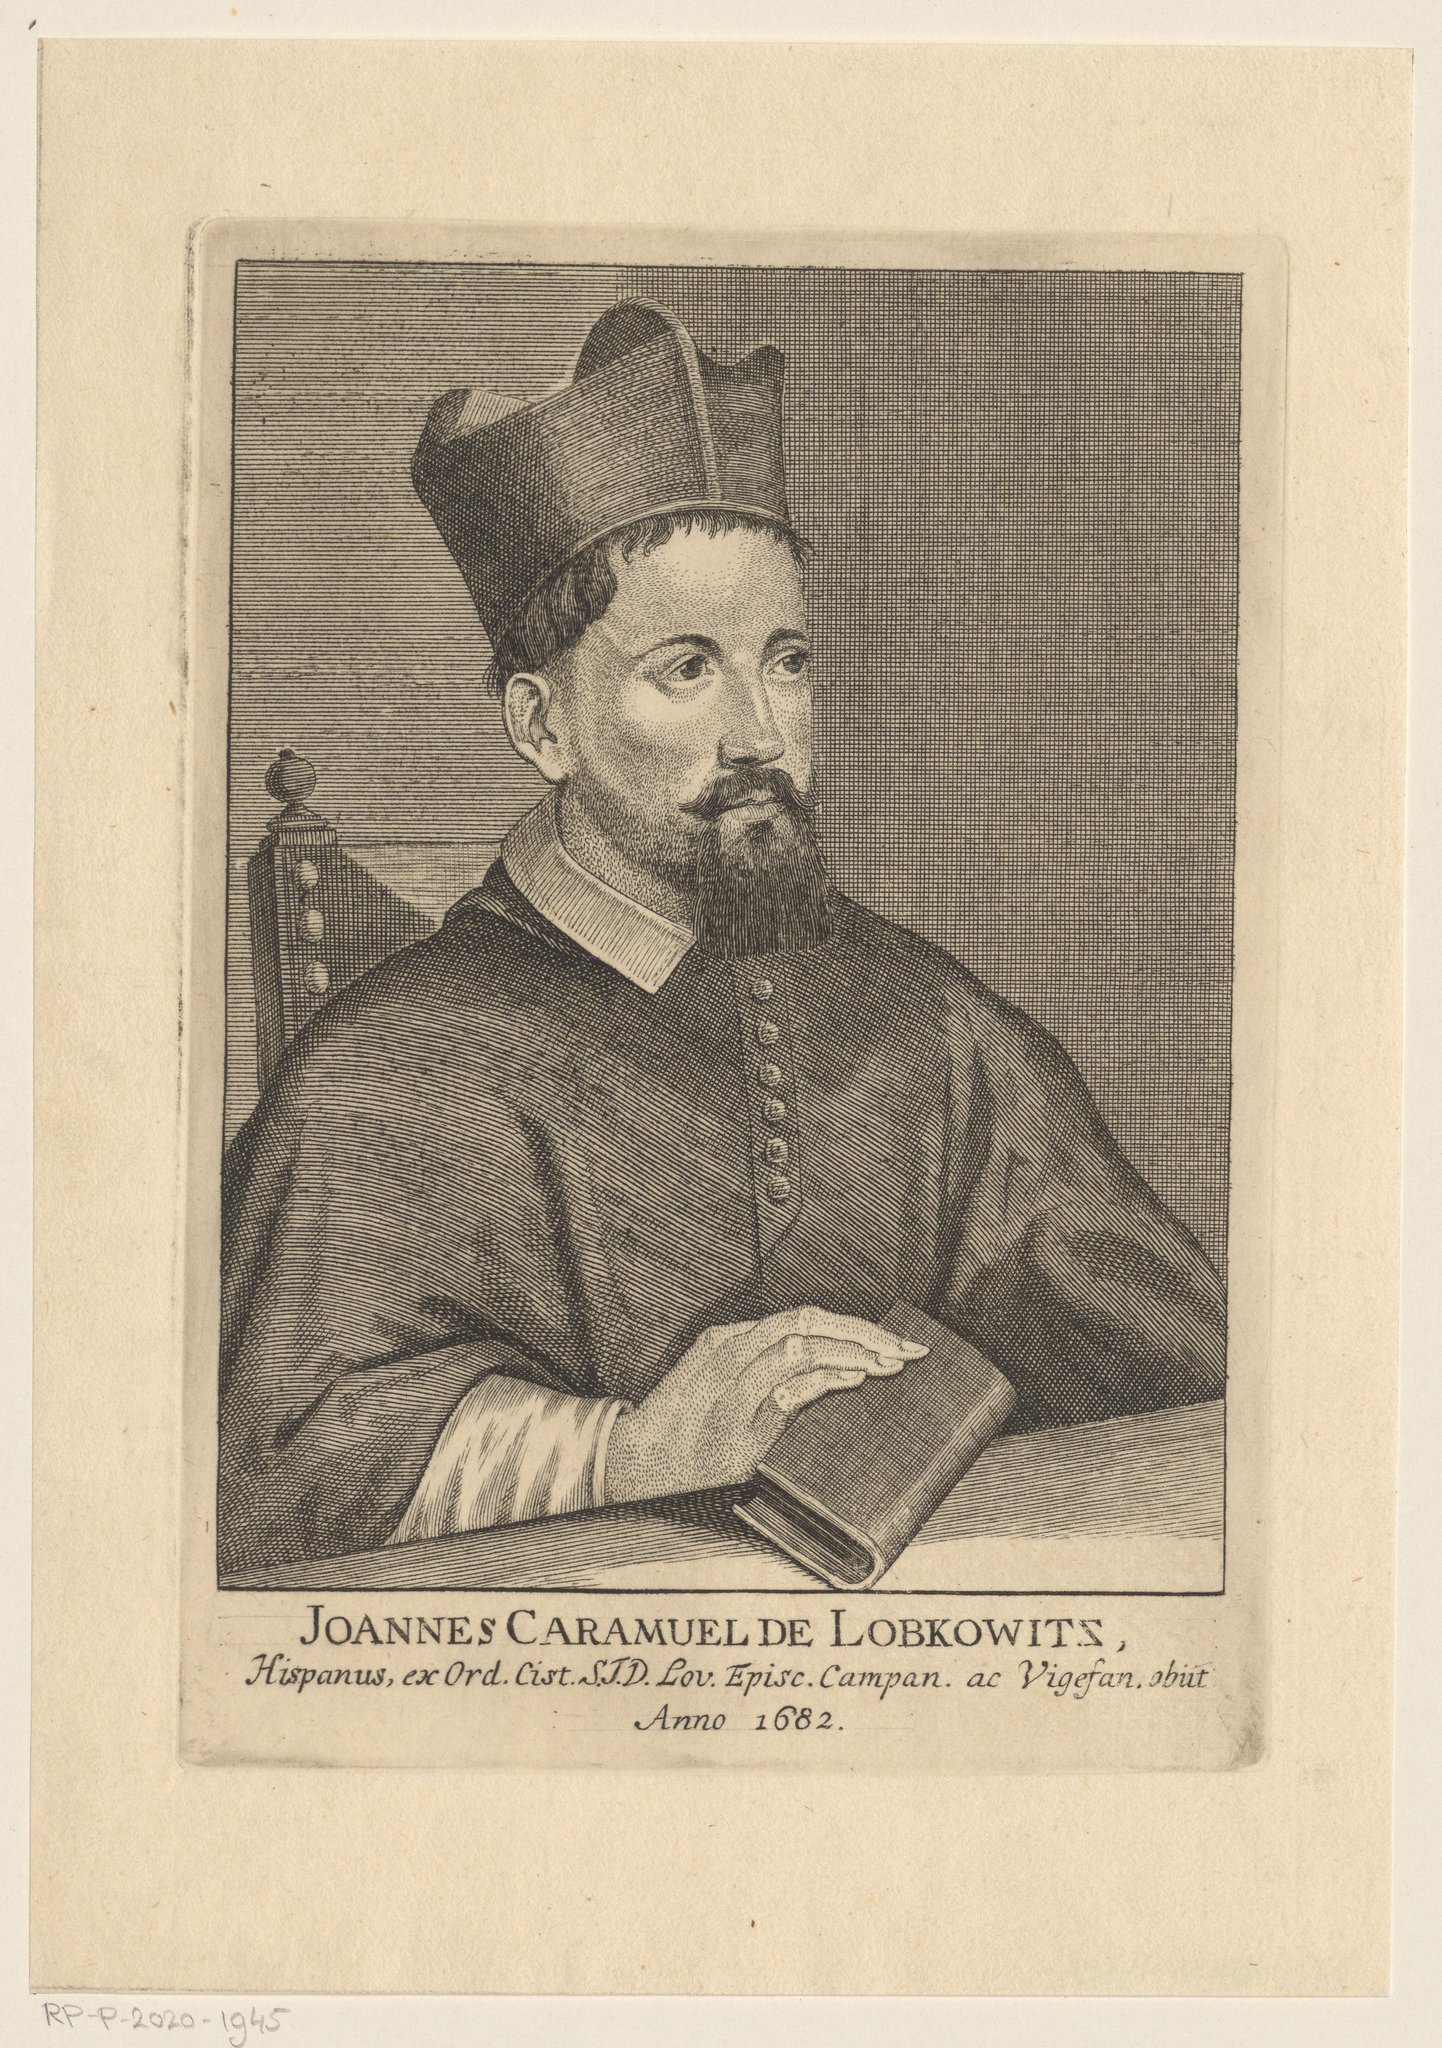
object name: print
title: Portret van Juan de Caramuel Lobkowitz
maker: Anonymous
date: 1682-1749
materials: paper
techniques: engraving, etching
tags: clergyman, historical persons